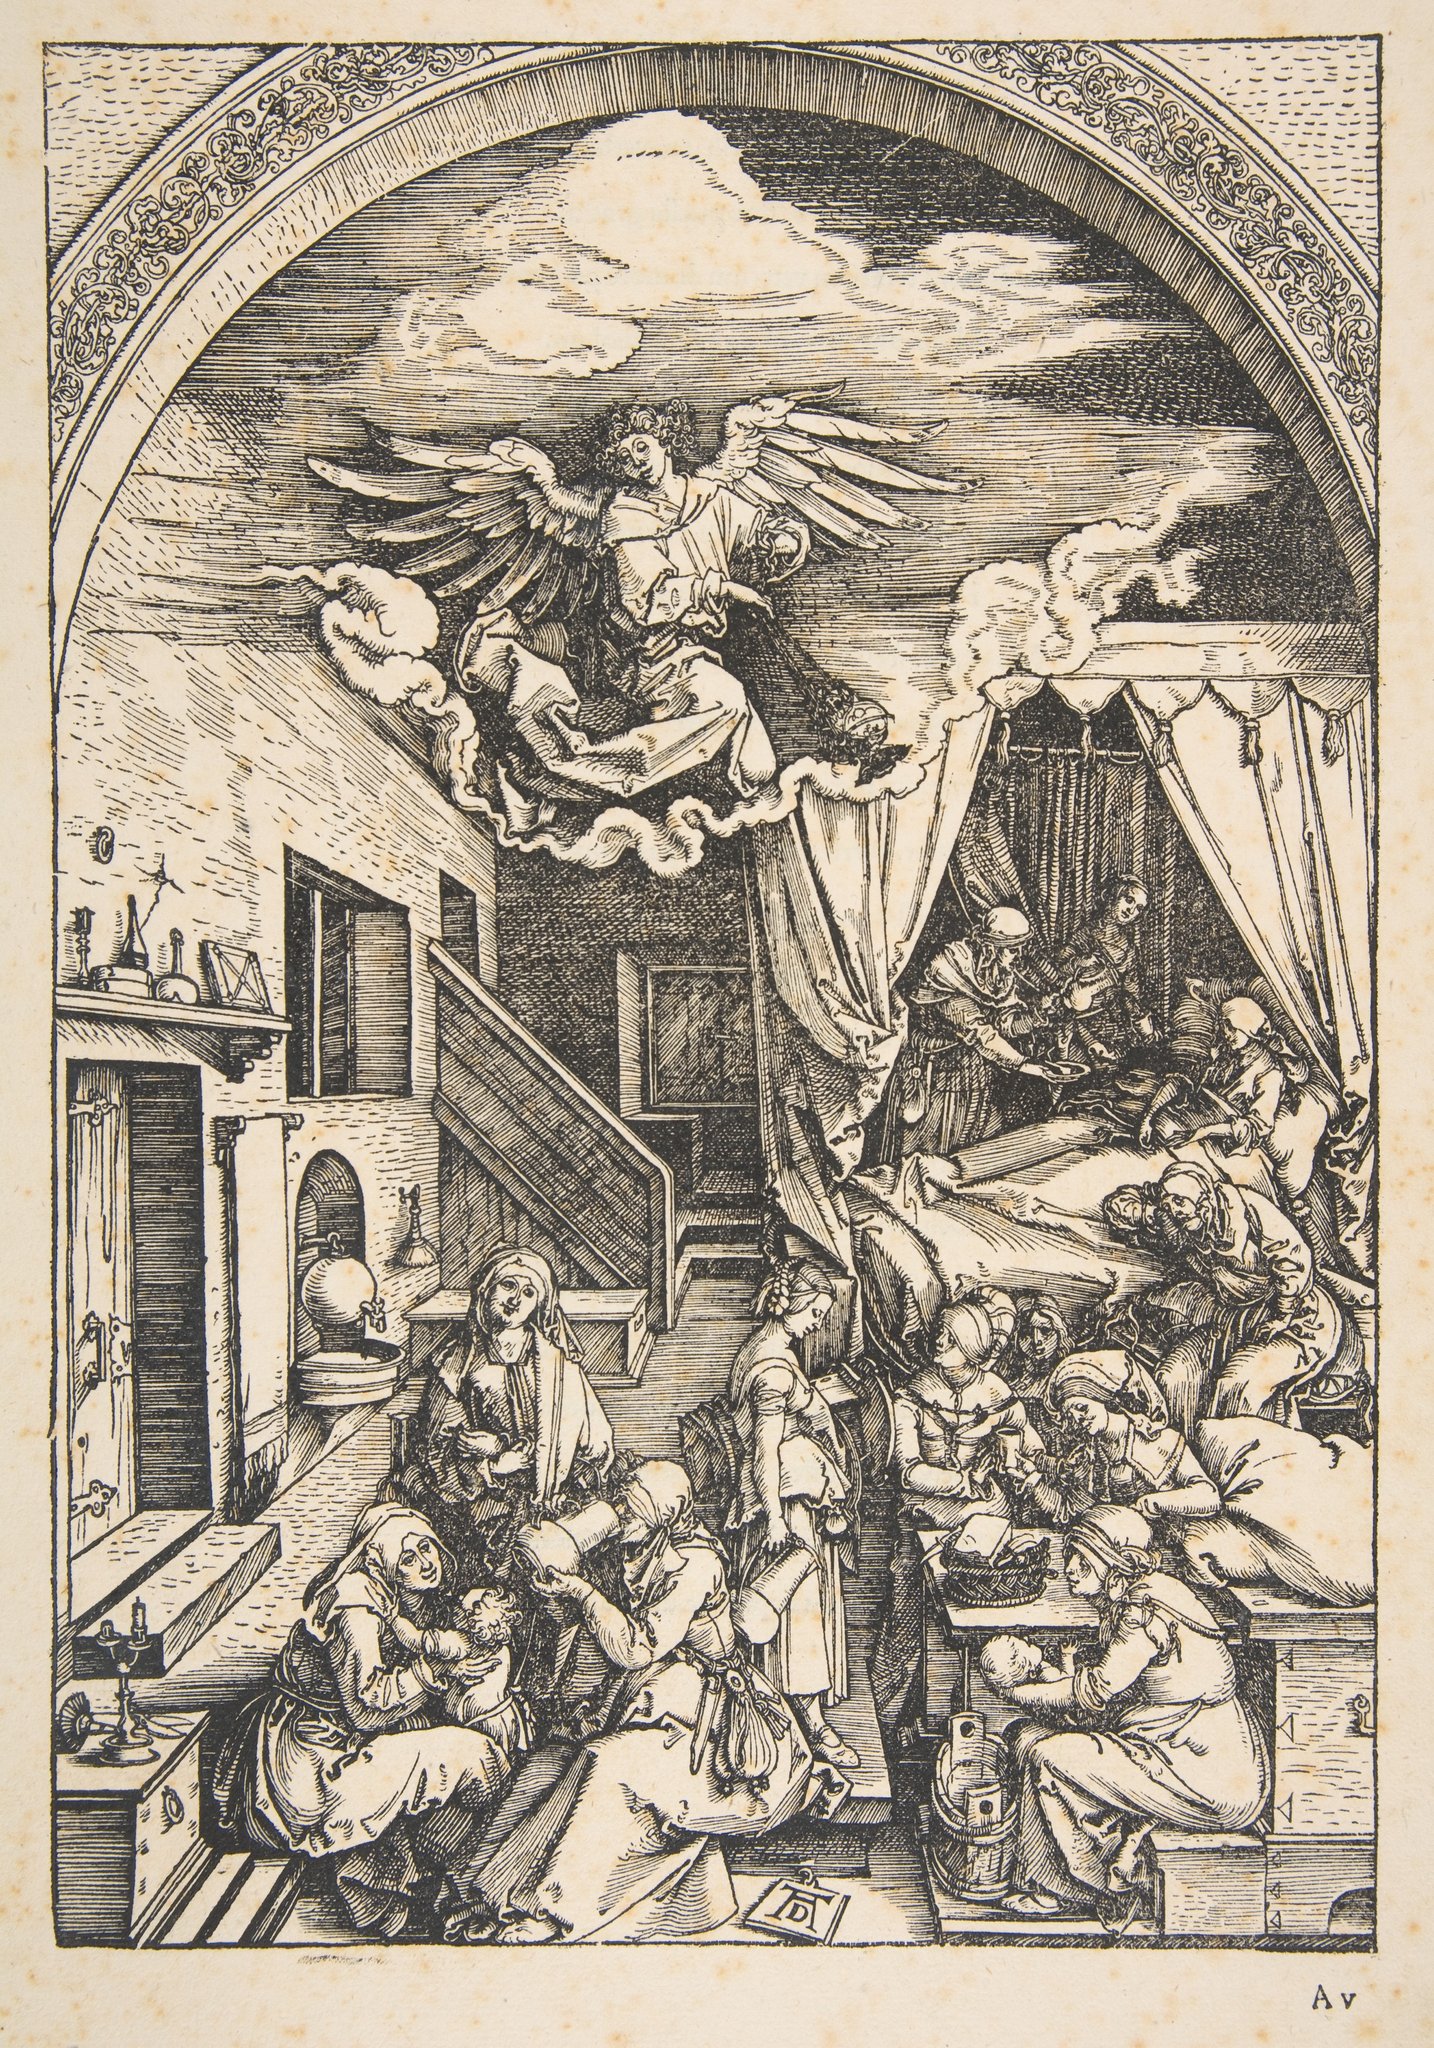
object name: print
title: The Birth of the Virgin, from "The Life of the Virgin"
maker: albrecht dürer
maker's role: artist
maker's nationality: german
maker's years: 1471-1528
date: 1503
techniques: woodcut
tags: angels,virgin mary,nativity